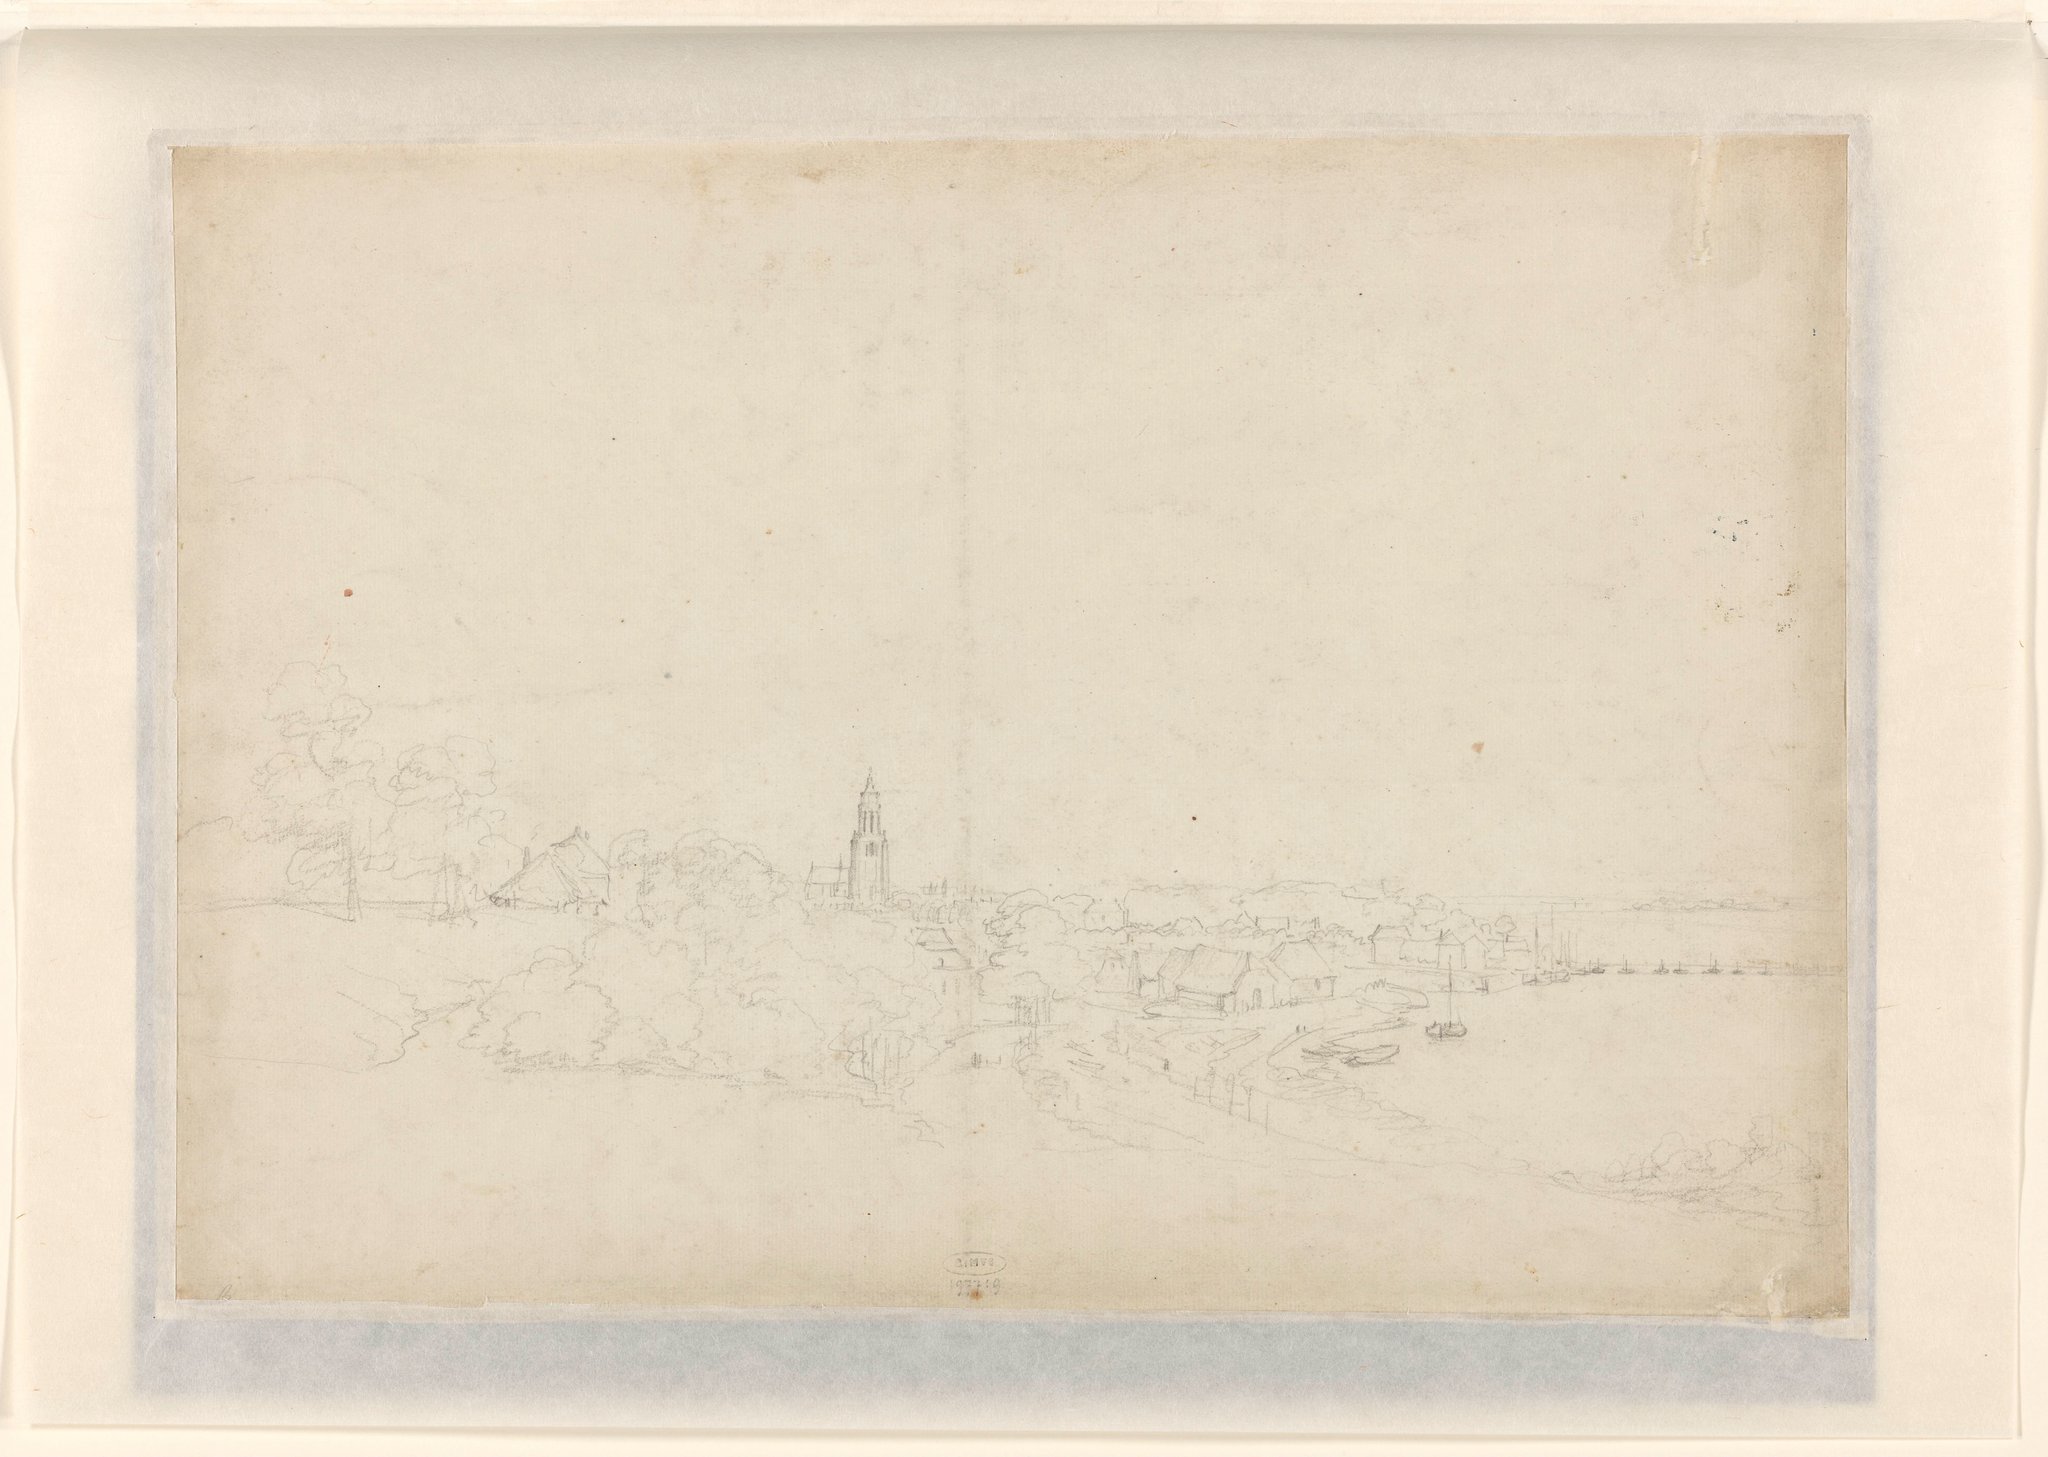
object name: drawing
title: Gezicht op Arnhem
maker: lodewijk johannes kleijn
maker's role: draughtsman, print maker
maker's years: 1817-1897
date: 1827-1897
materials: paper, pencil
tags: prospect of city, town panorama, silhouette of city, arnhem